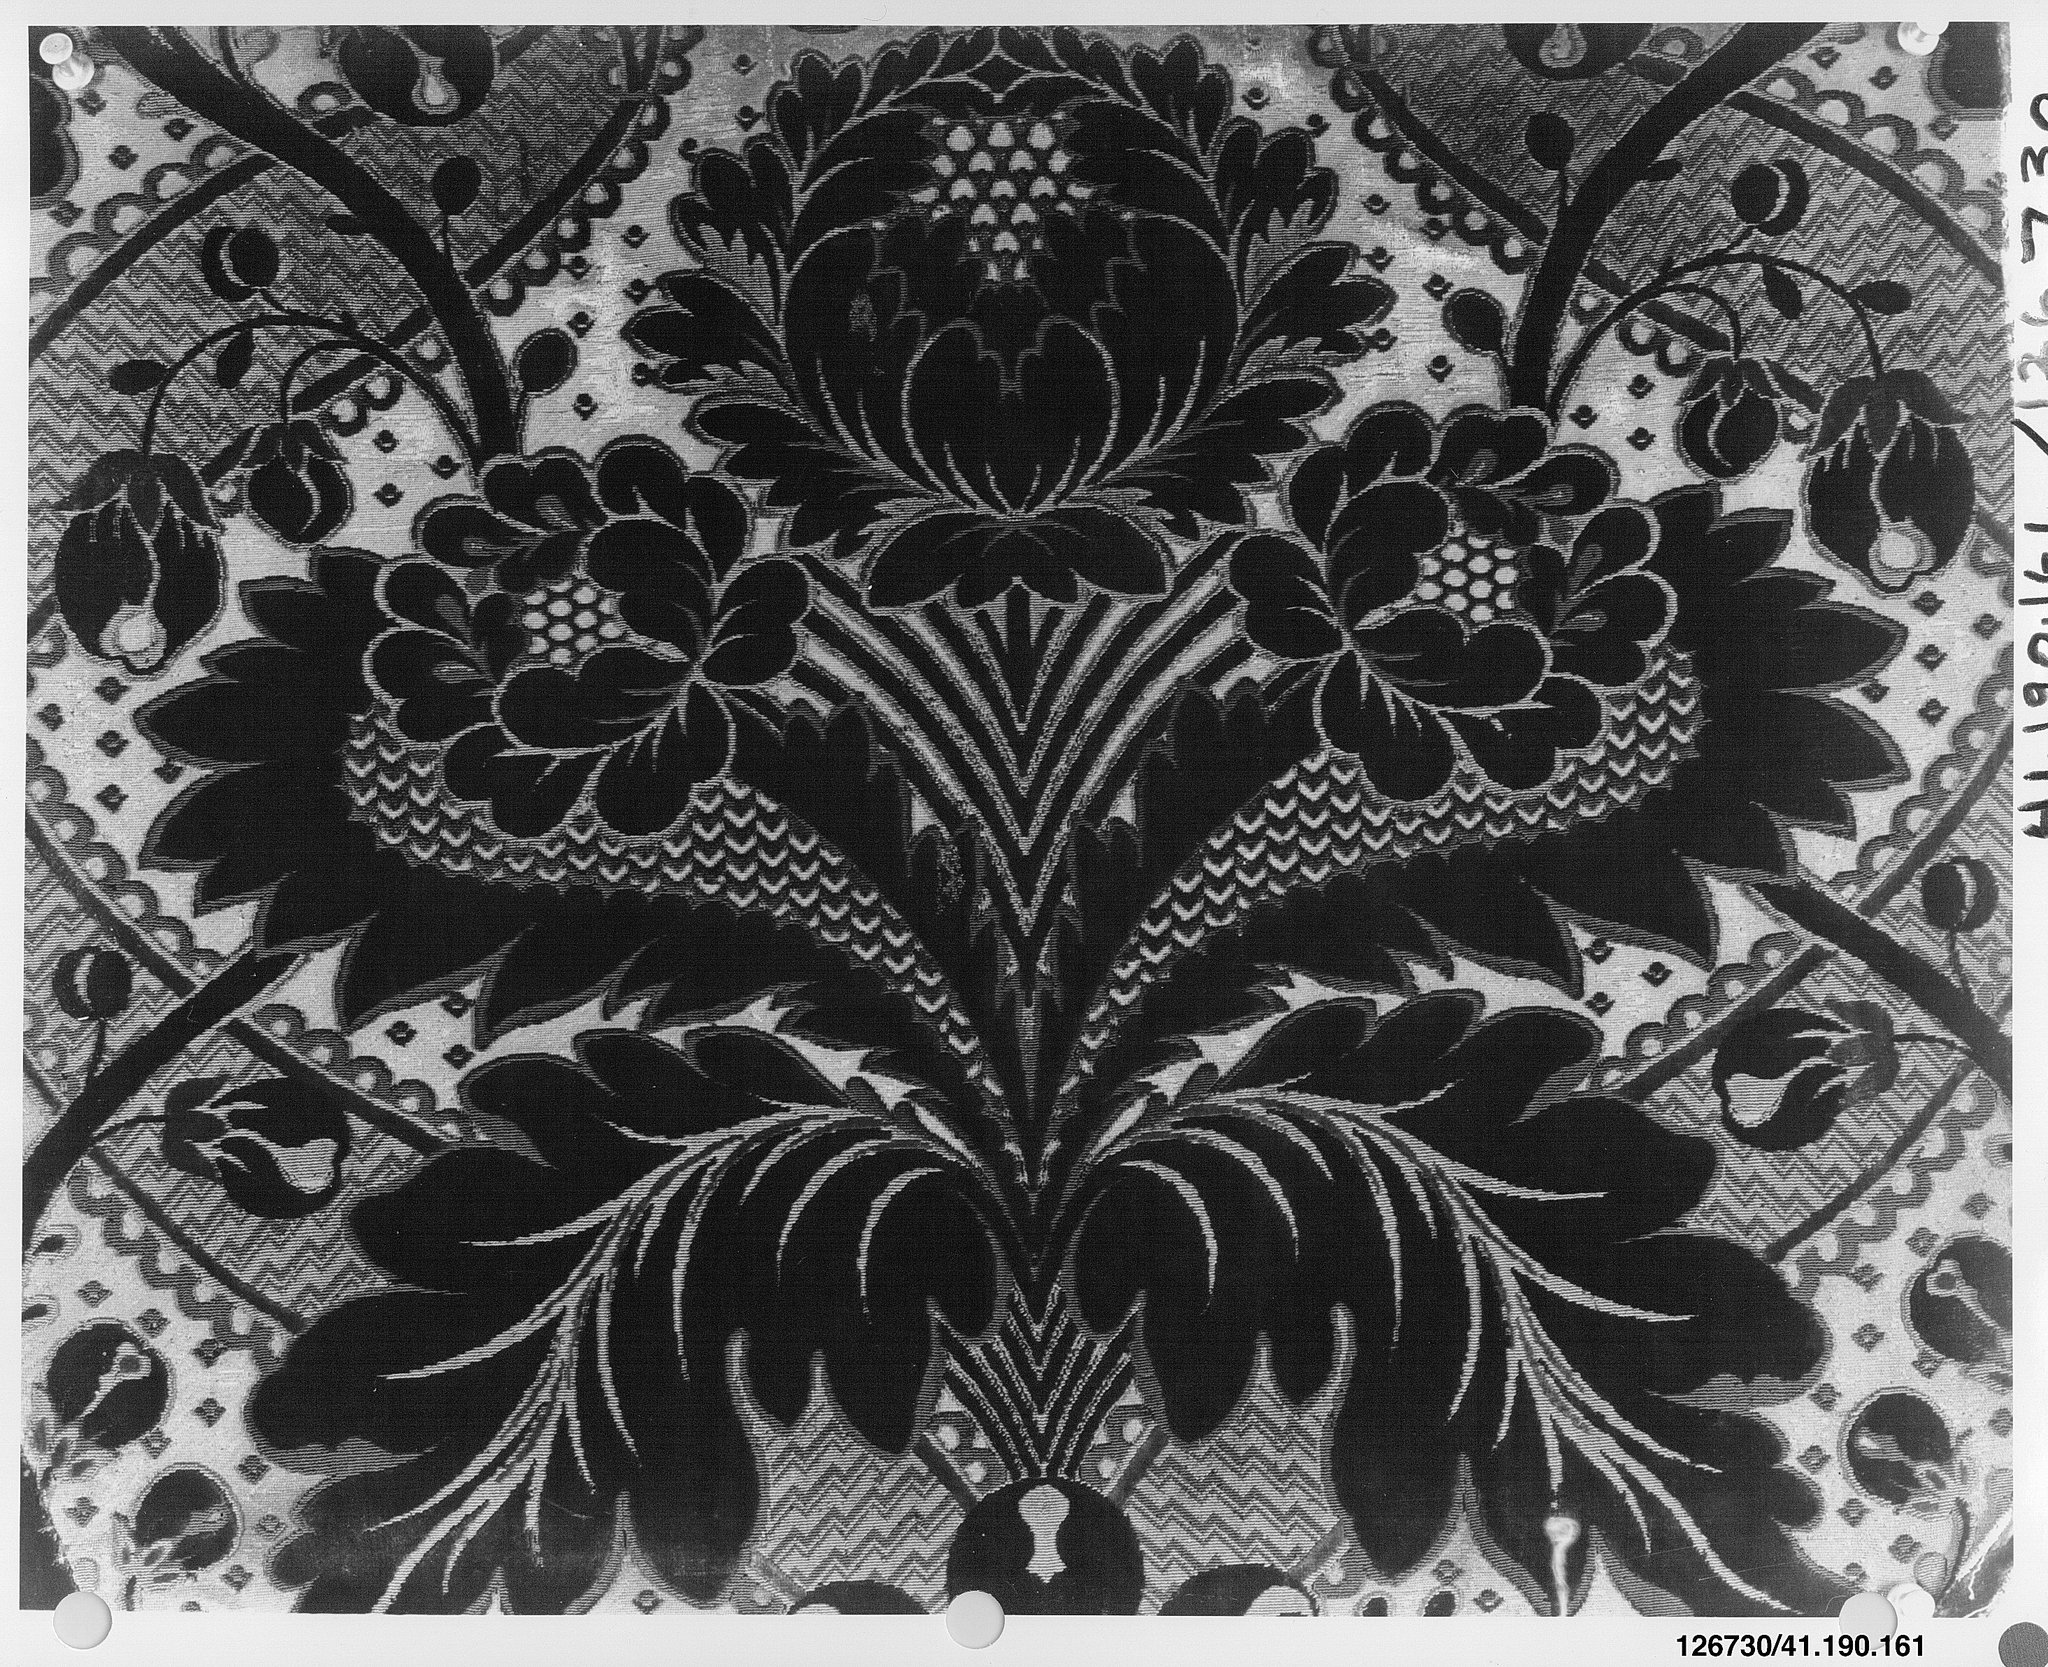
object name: piece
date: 1734-1766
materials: metal thread, silk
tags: flowers,leaves